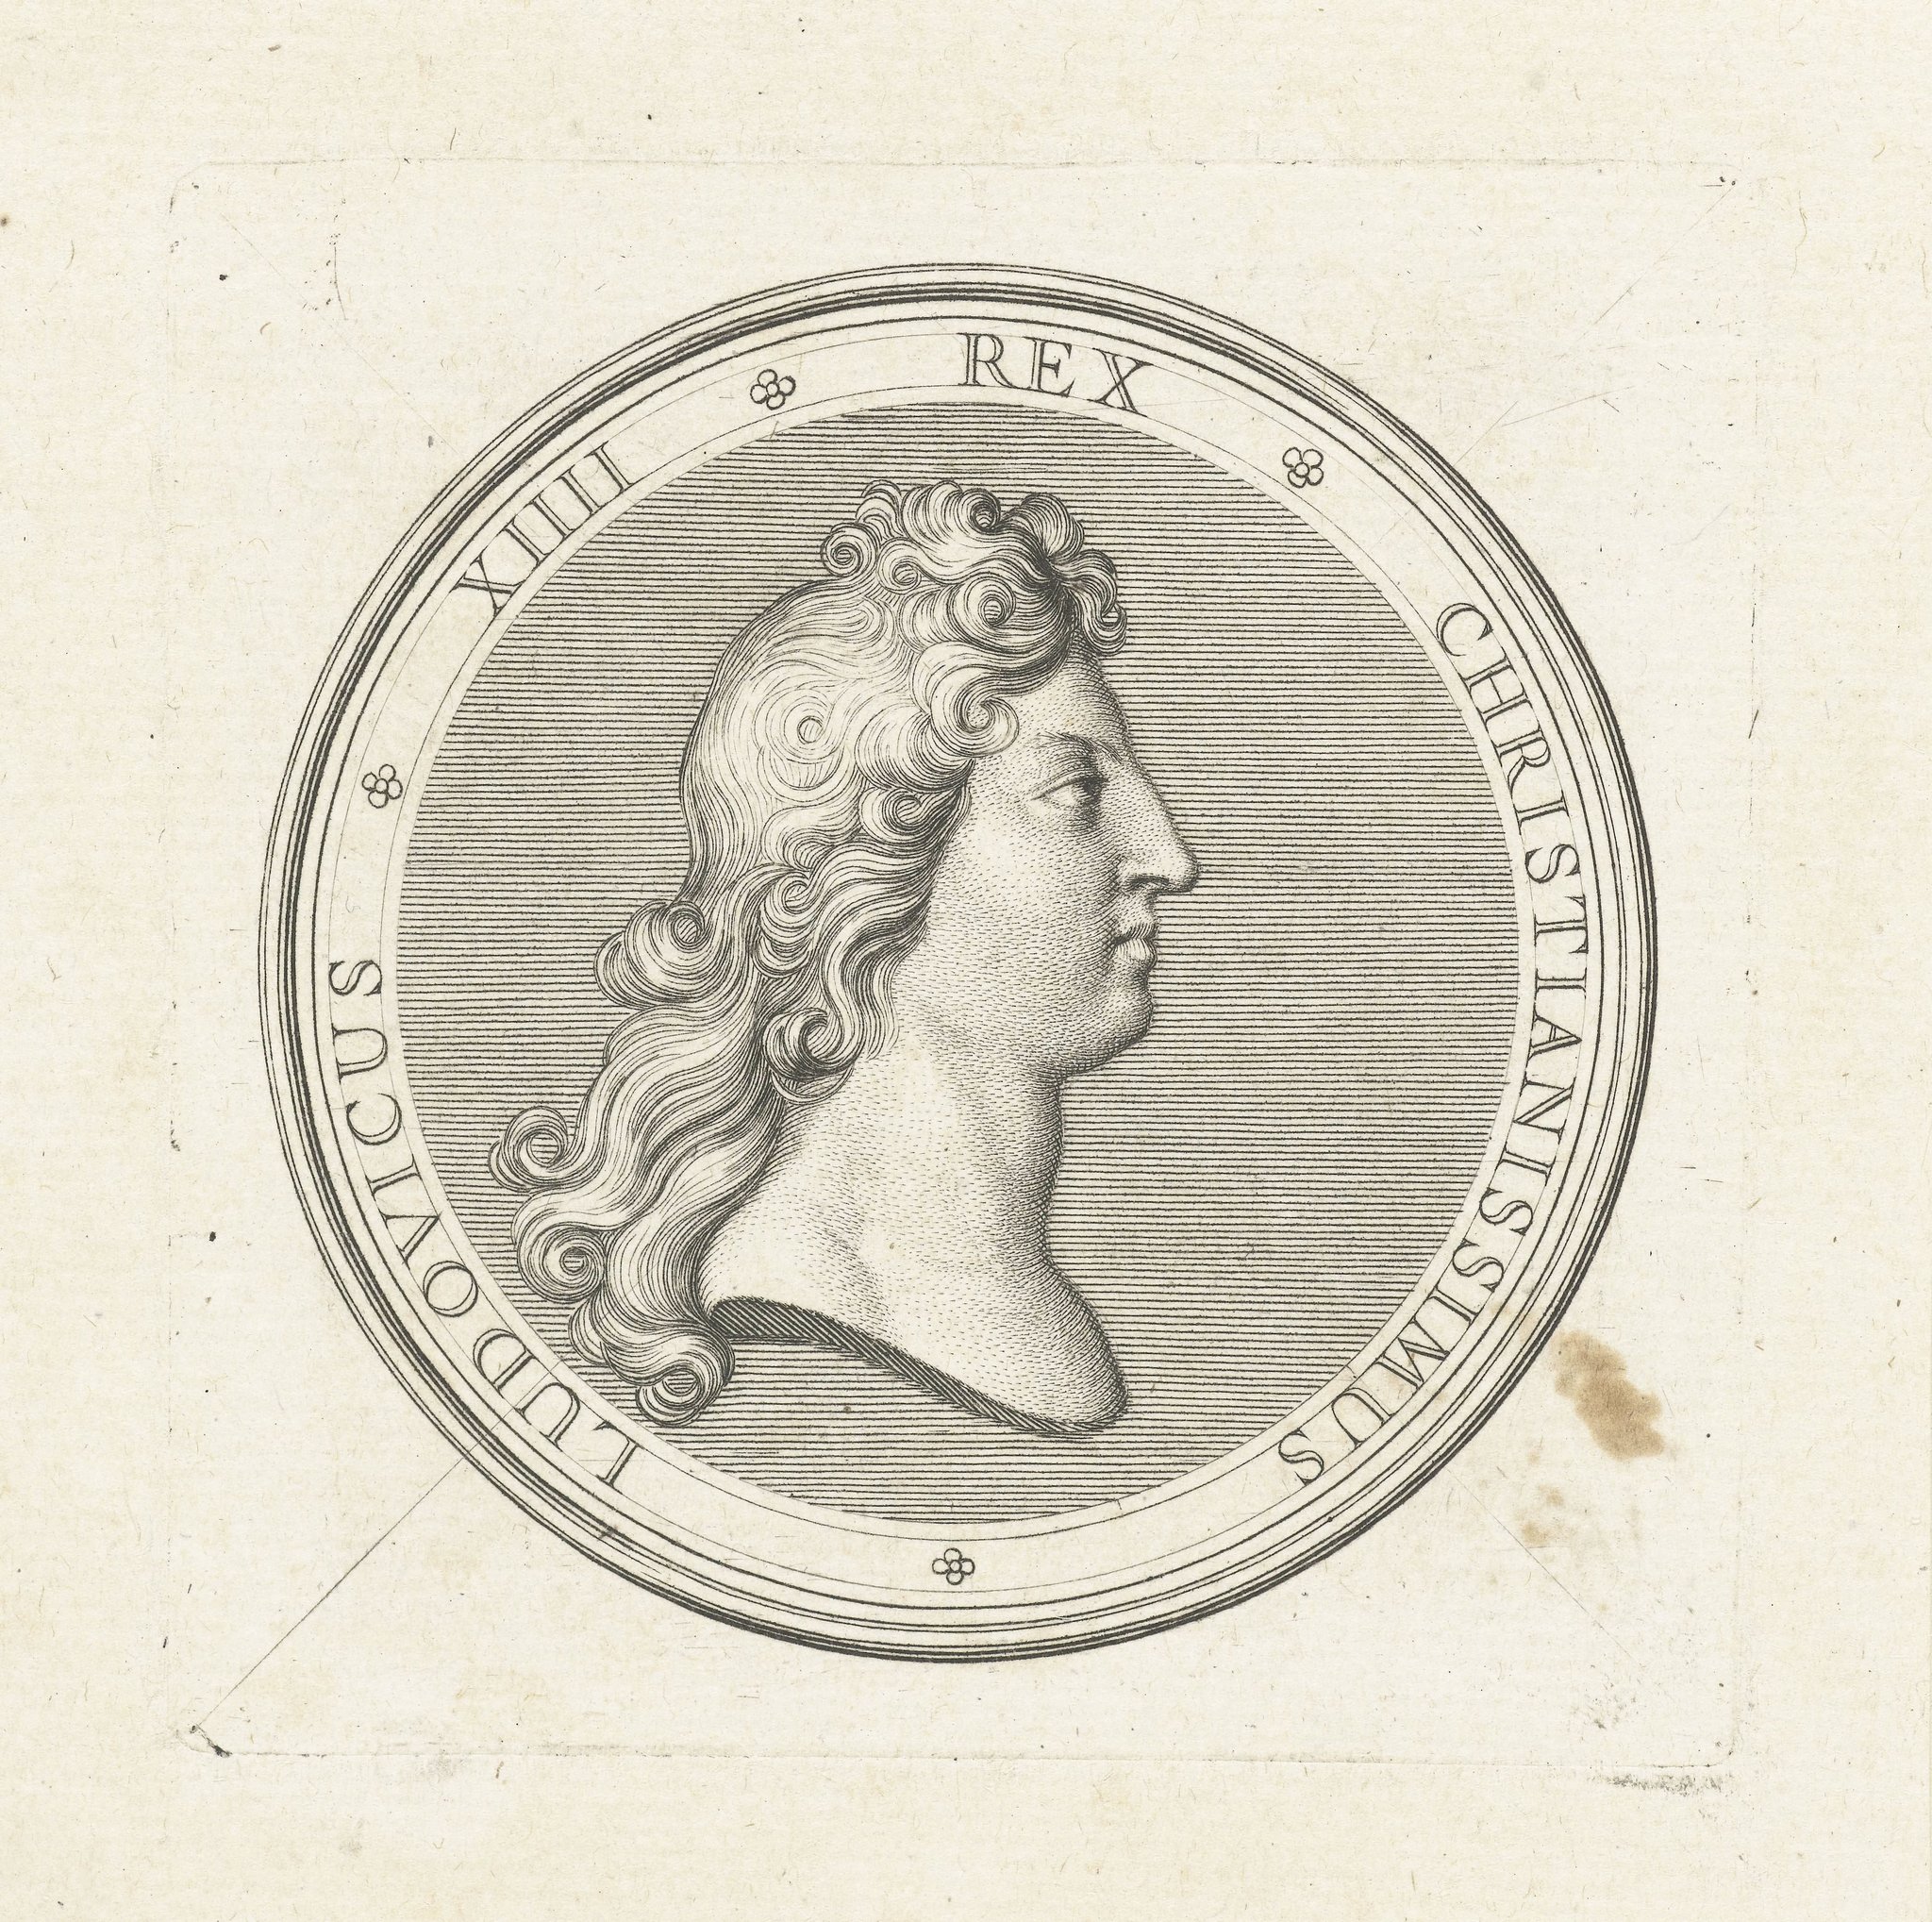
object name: print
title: Penning met buste van Lodewijk XIV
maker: gerard edelinck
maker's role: print maker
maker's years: 1640-1707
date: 1702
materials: paper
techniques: engraving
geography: paris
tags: lodewijk xiv (koning van frankrijk)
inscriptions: collector's mark: Lugt 240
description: Voorkant van een penning met buste en profil van Lodewijk XIV.